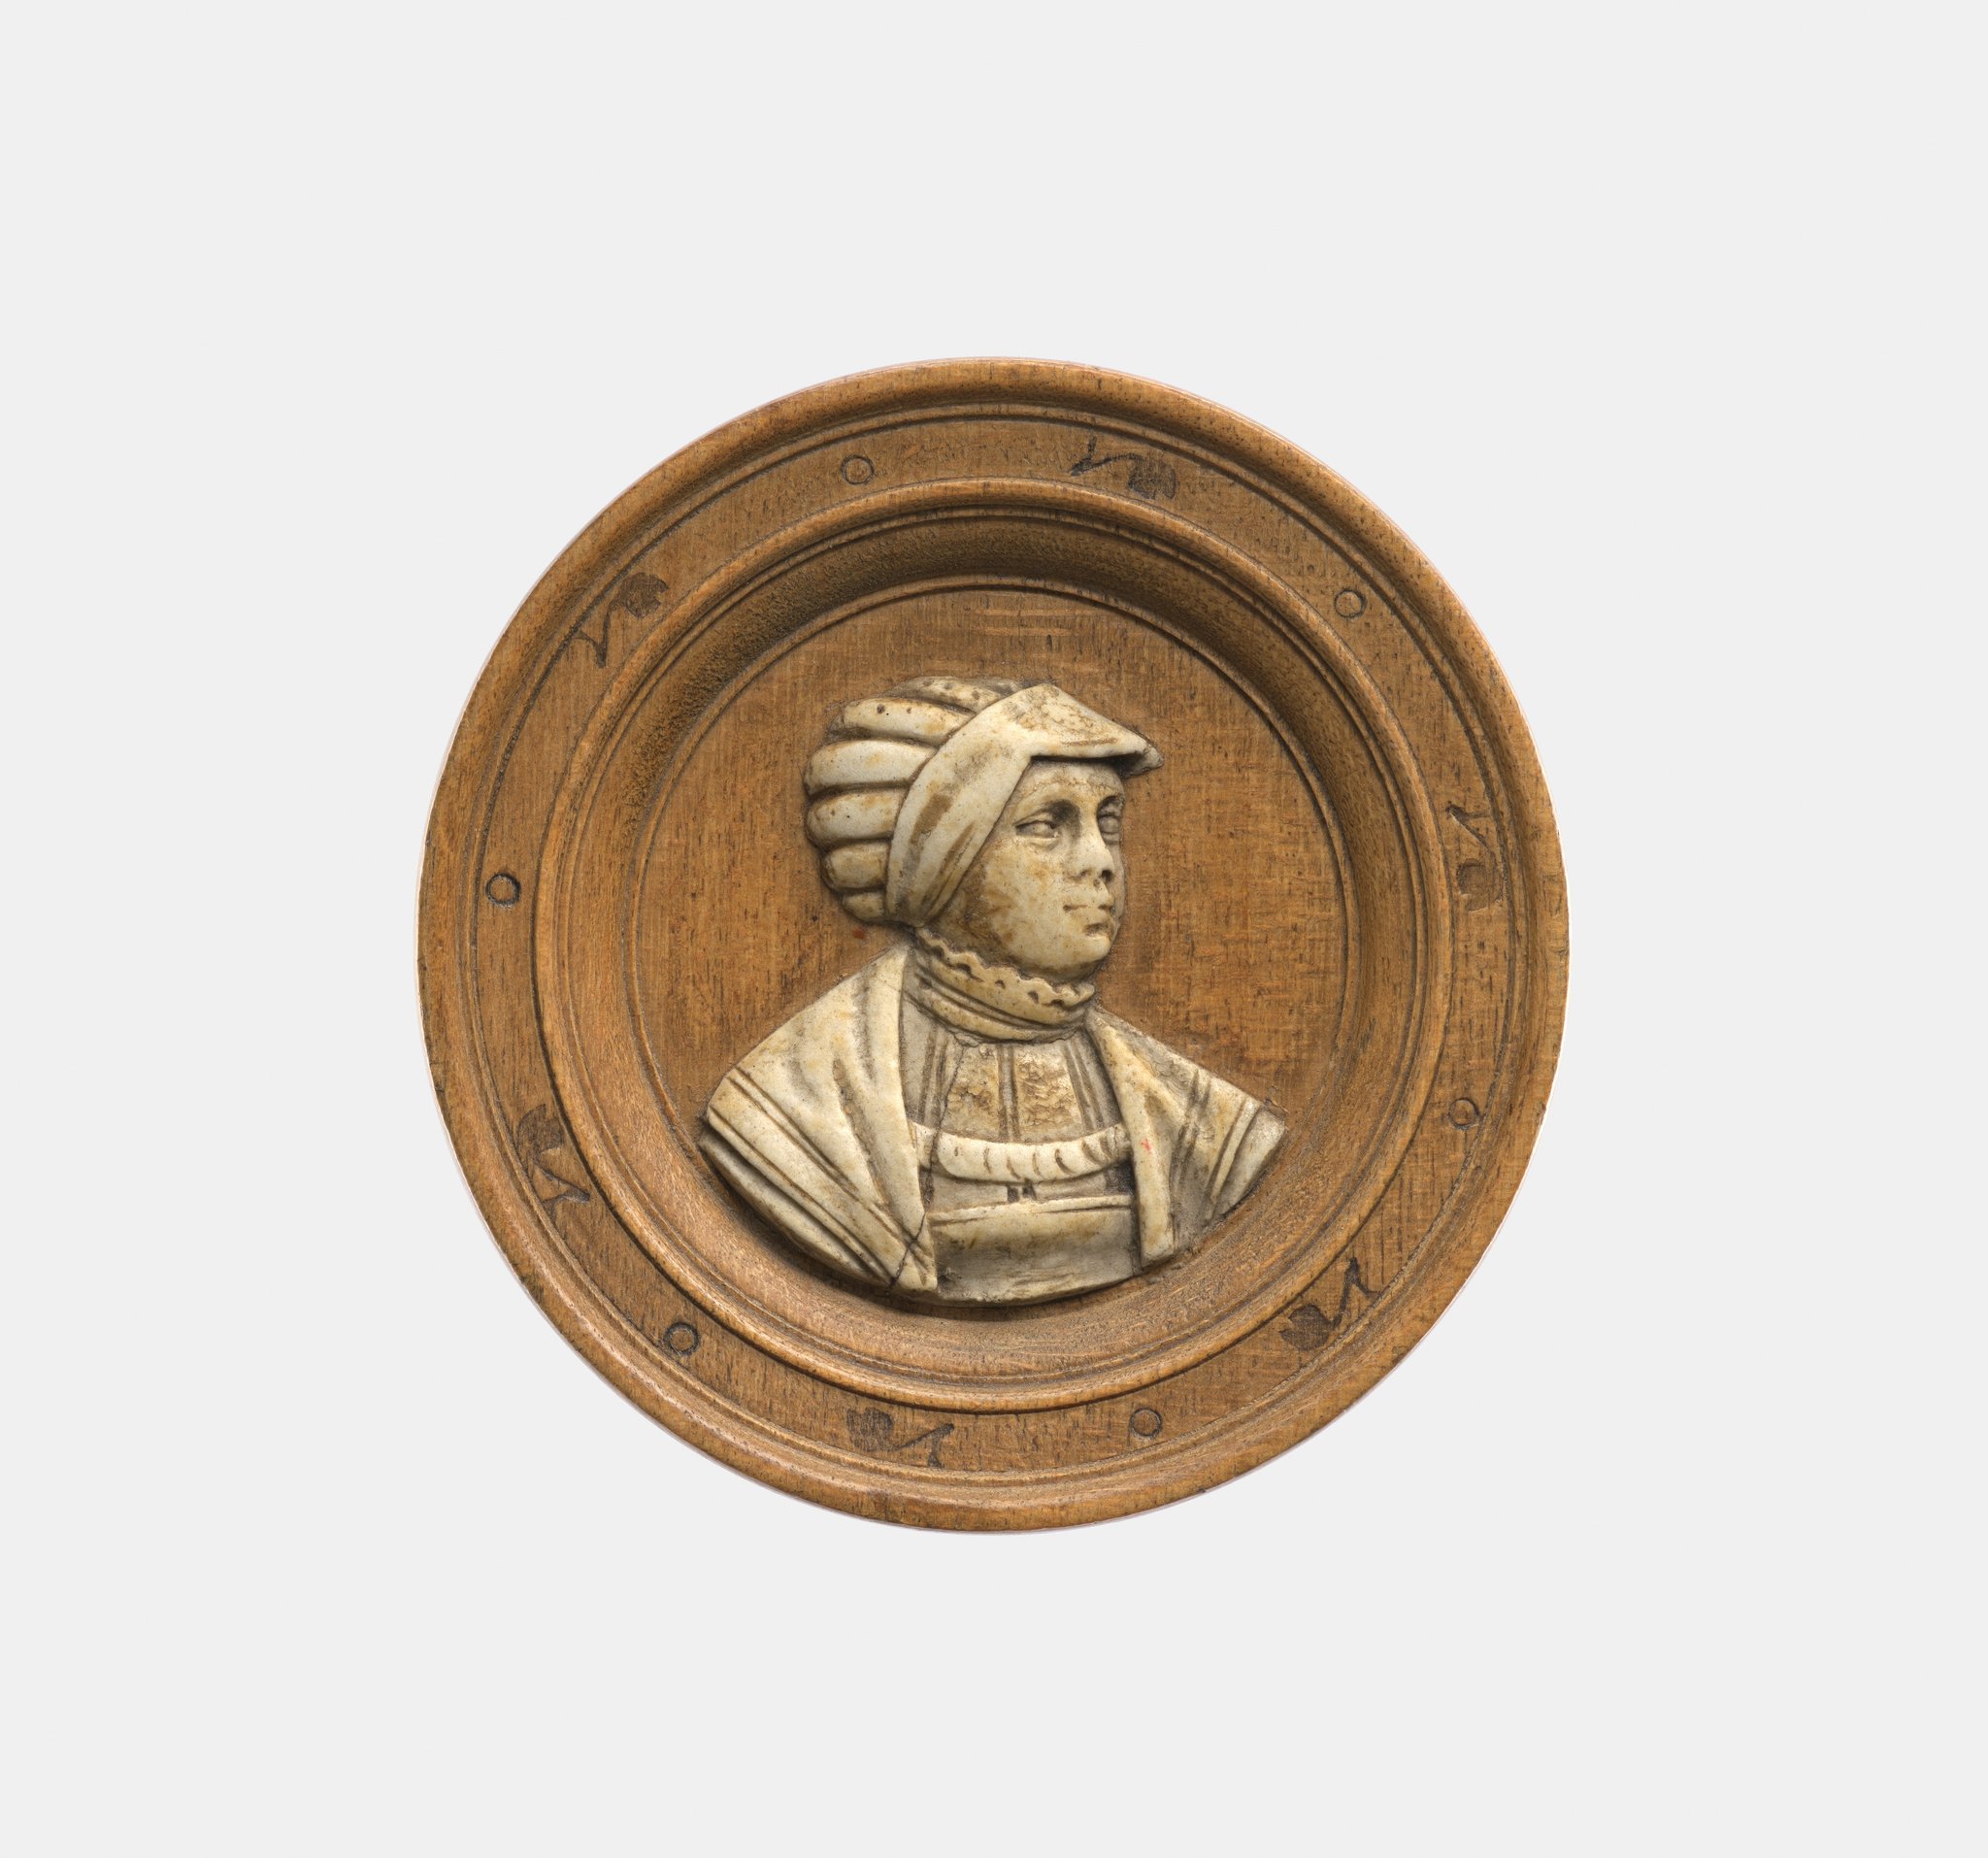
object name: checker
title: Emerentiana von Tannhausen, married 1521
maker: Anonymous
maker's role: artist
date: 1530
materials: marble, wood